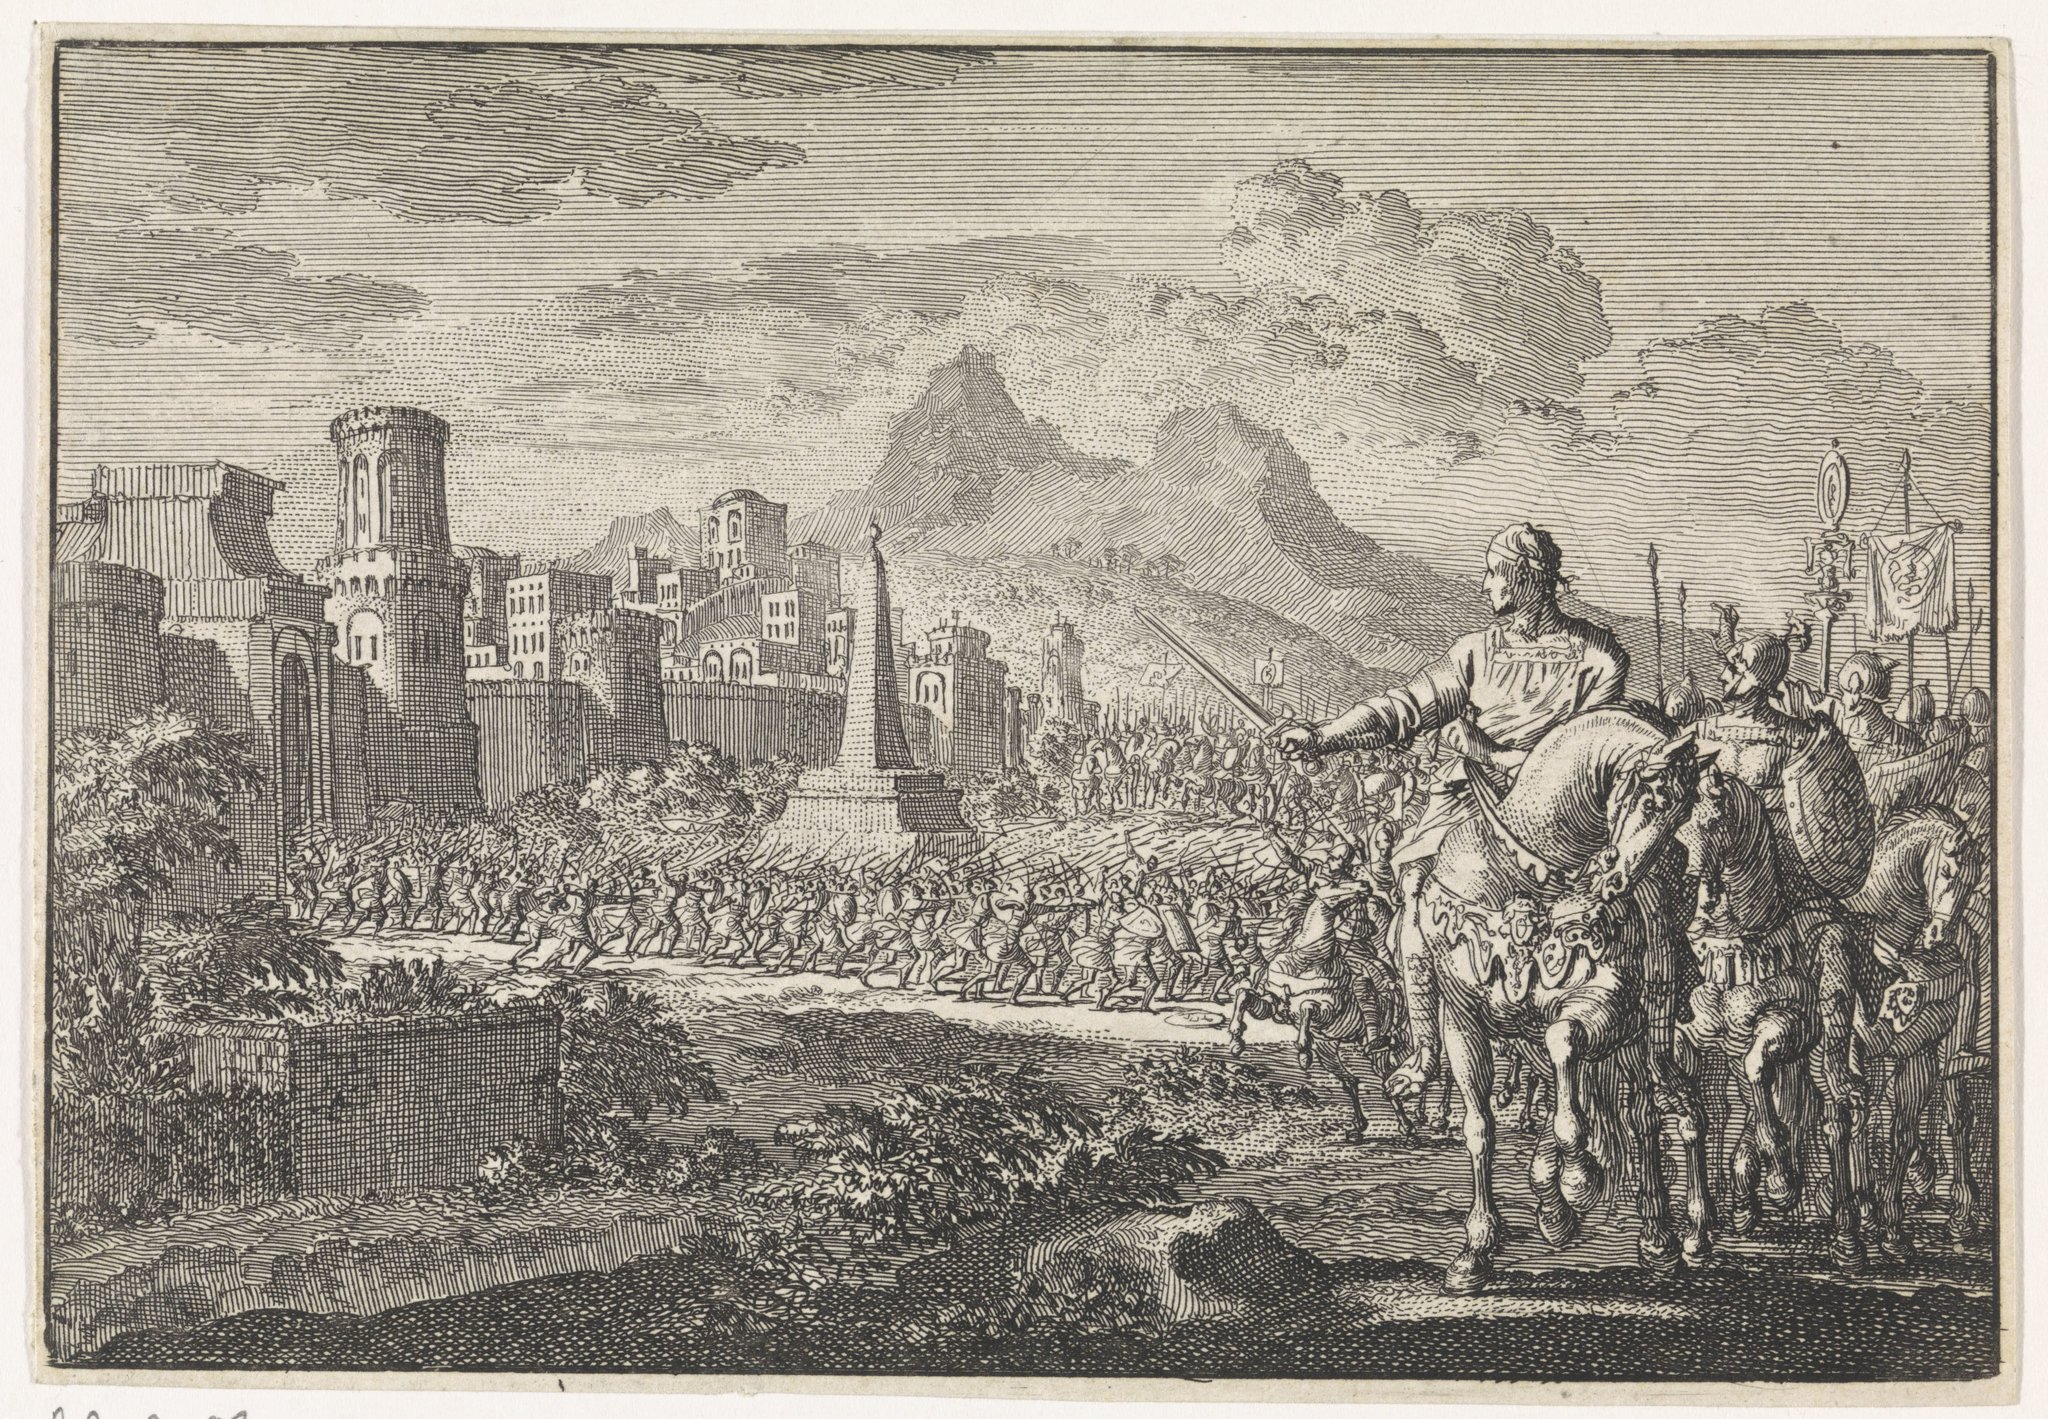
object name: print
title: Titus met enkele ruiters van zijn andere volgelingen afgesneden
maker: jan luyken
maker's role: draughtsman, print maker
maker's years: 1649-1712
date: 1704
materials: paper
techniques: etching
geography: amsterdam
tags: warfare; military affairs (+ cavalry, horsemen)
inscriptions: collector's mark: Lugt 2228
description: Prent ook gebruikt als boekillustratie in: Josephus, Flavius. Alle de Werken, 2 delen. Amsterdam: Pieter Mortier, 1704, dl. 2, p. 652.